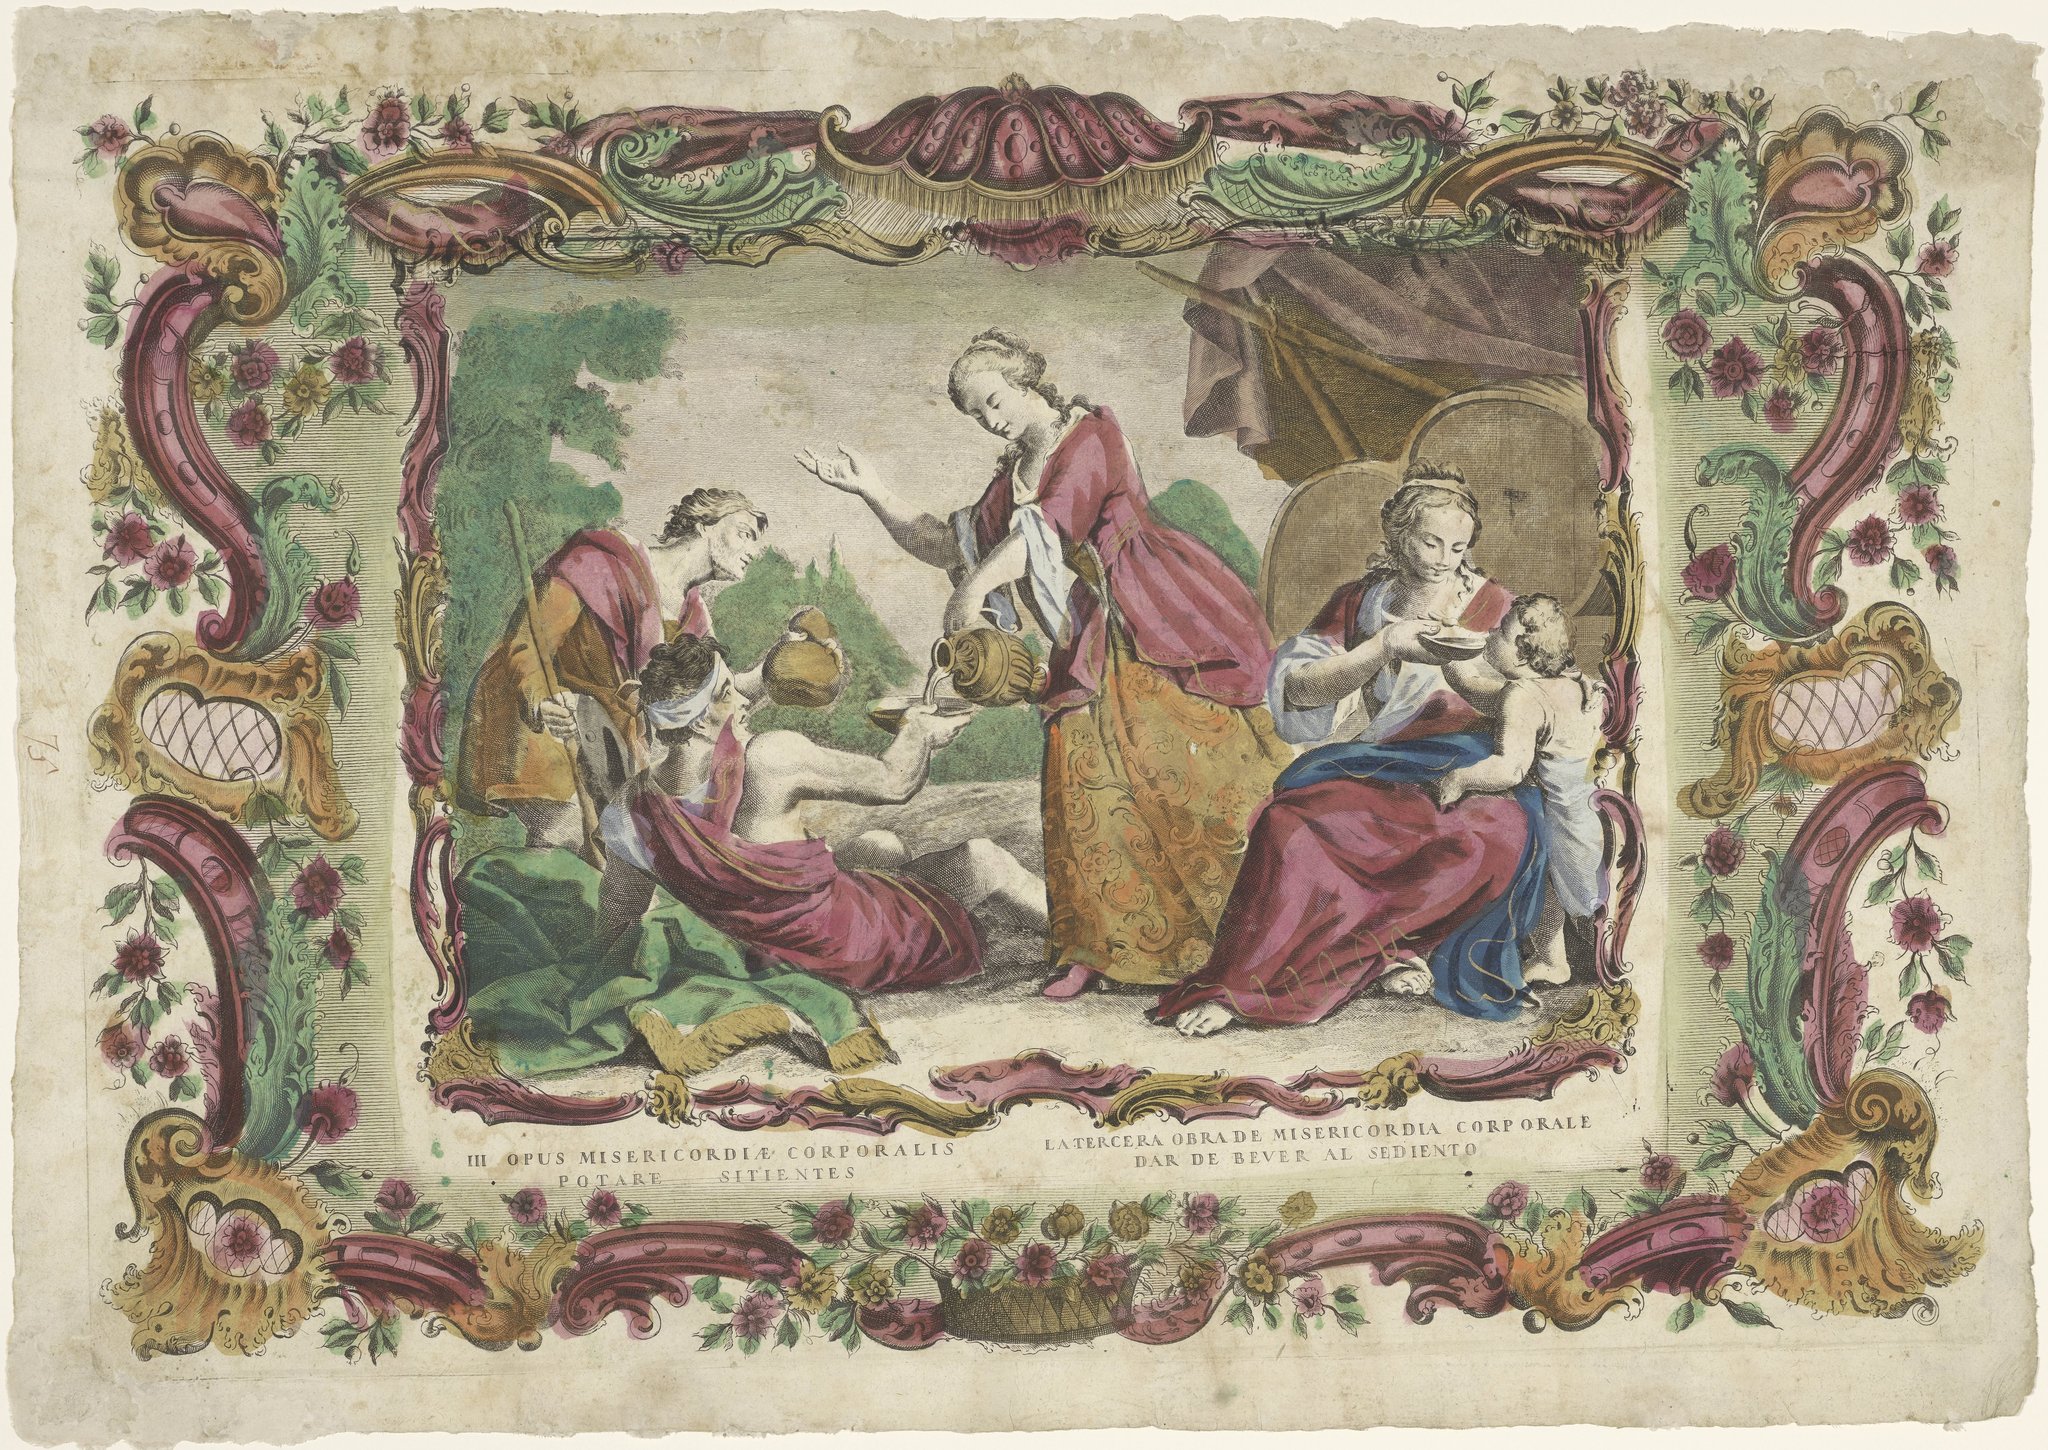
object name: print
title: III. opus misericordiae corporalis / Latercera obra de misericordia corporal (...)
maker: giovanni volpato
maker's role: ceramicist, print maker, printer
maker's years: 1735-1803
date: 1700-1799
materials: paper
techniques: colour, engraving, etching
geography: italy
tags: ornaments ~ art, giving the thirsty to drink, 'sitiens potatur' ~ one of the (seven) acts of mercy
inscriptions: collector's mark: Lugt 2228, collector's mark: Lugt 2760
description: Uitbeelding van één van de spirituele werken van barmhartigheid: de dorstigen laven. Rechts geeft een vrouw die voor een paar tonnen op de grond zit, een klein kind te drinken uit een schaaltje. In het midden een staande vrouw die twee bedelaars te drinken geeft uit haar kruik. Titel onder de voorstelling. De scène is gevat in een ornamentrand.